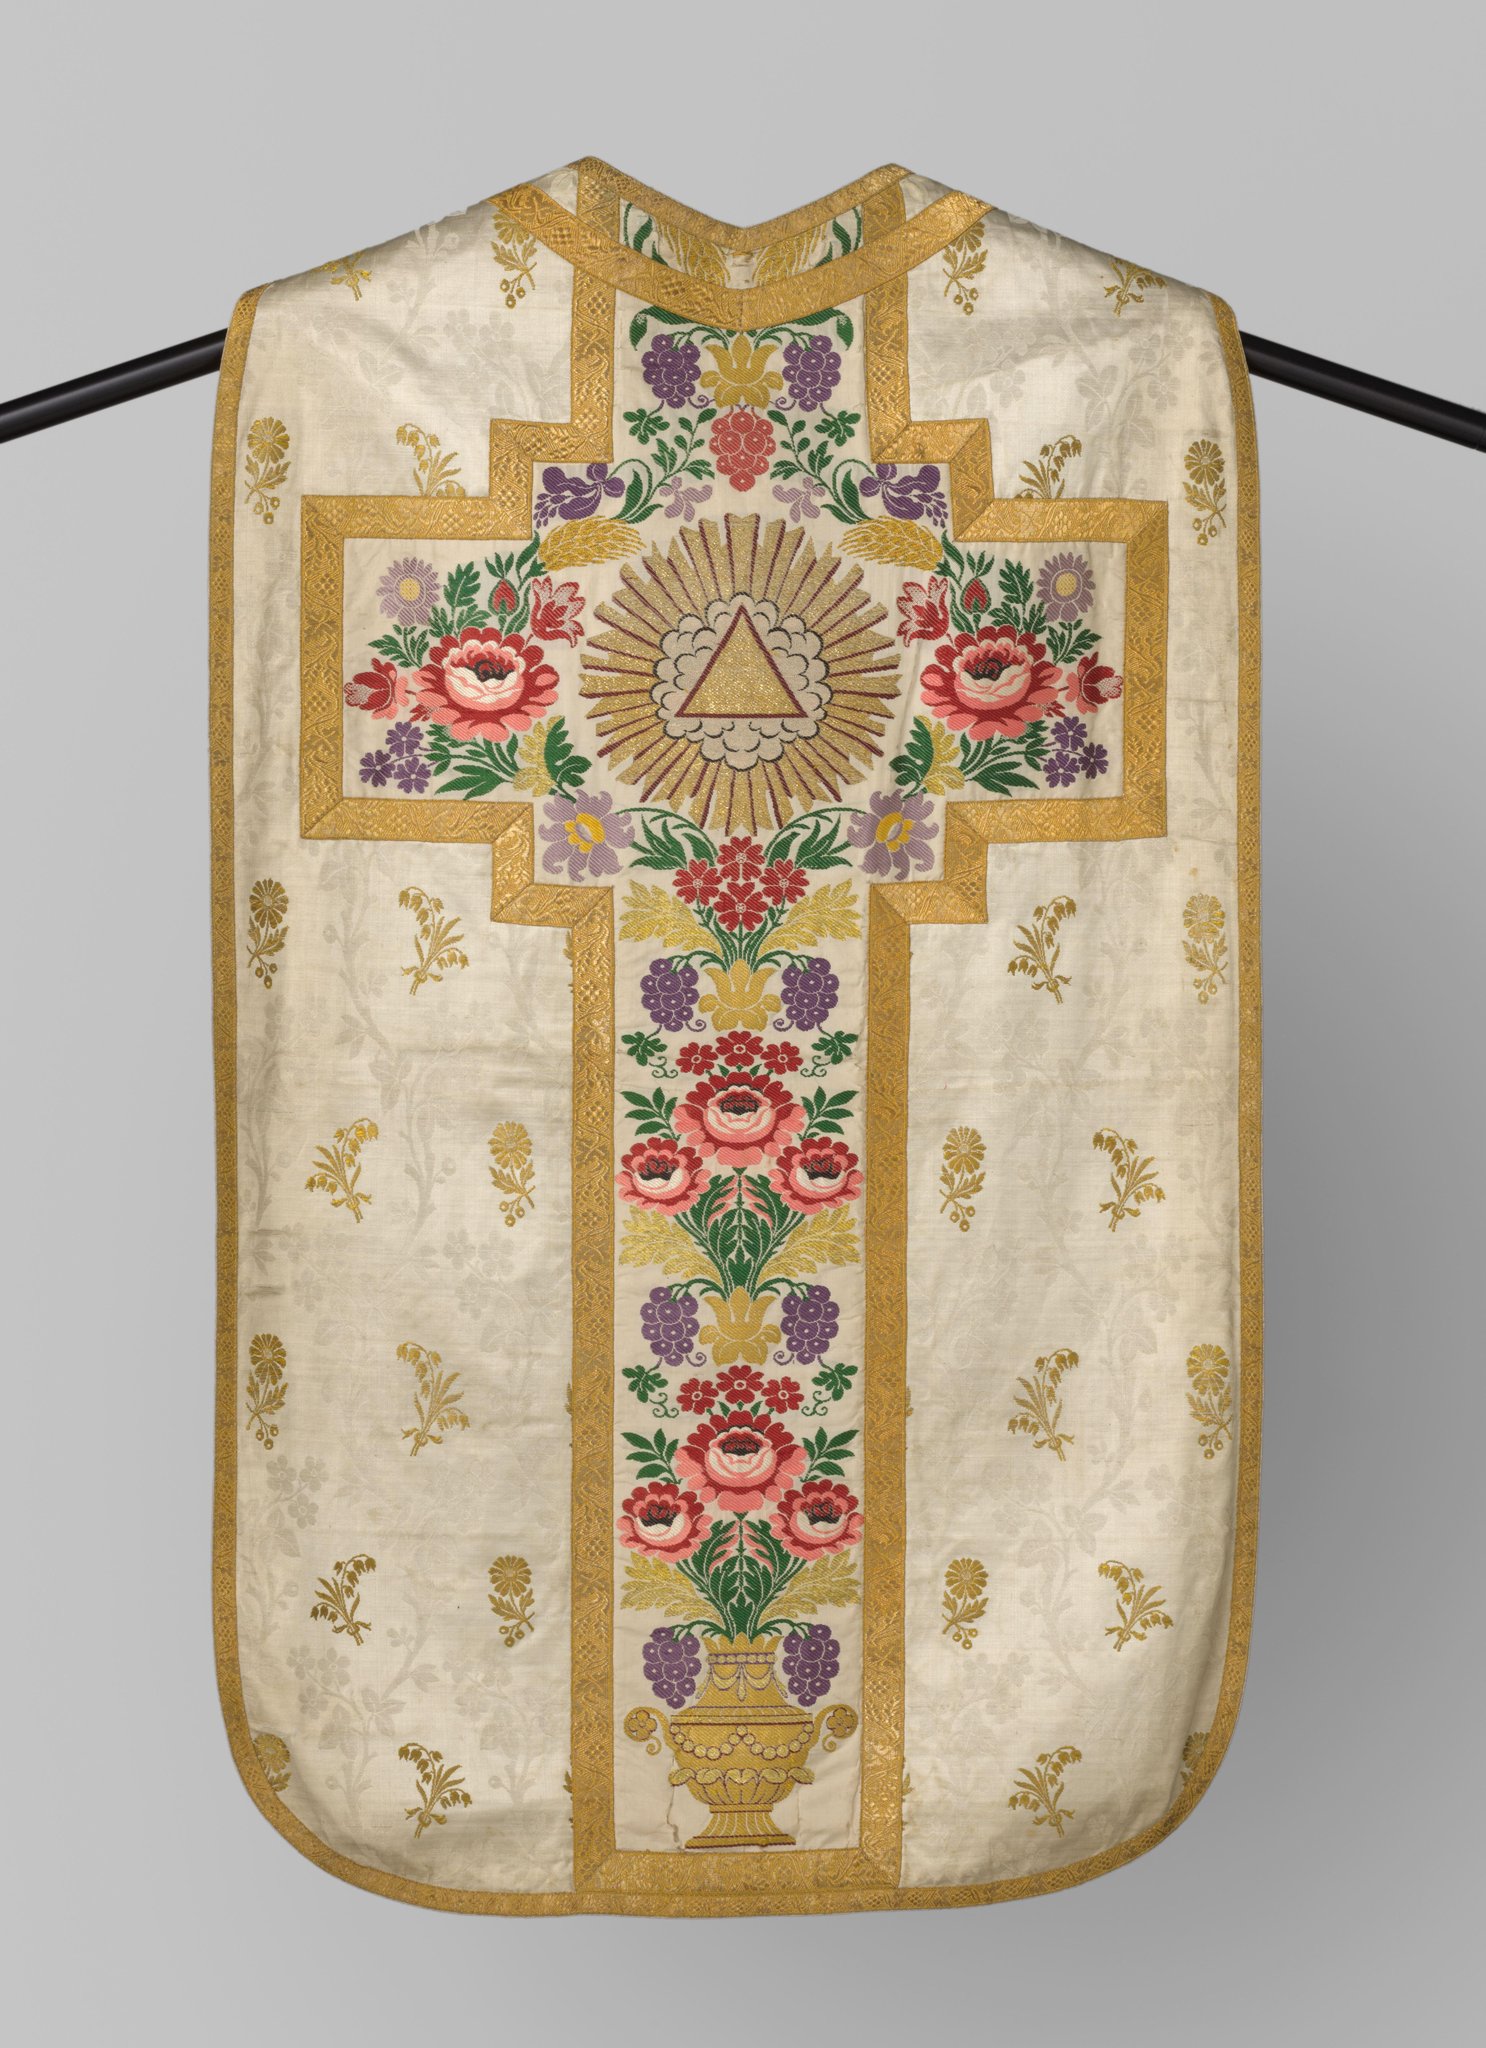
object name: clothing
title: Kazuifel van wit brokaat: op rugkruis een ingeweven driehoek in stralenkrans en met natuurlijk gekleurde druiven en rozen in vaas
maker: l.h. devisée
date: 1839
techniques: brocade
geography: namur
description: Kazuifel van wit brokaat: op rugkruis een ingeweven driehoek in stralenkrans en met natuurlijk gekleurde druiven en rozen in vaas. Gesigneerd: fecit L.H. Deviséee (onduidelijk), Namuri hac 21 Martii 1839.